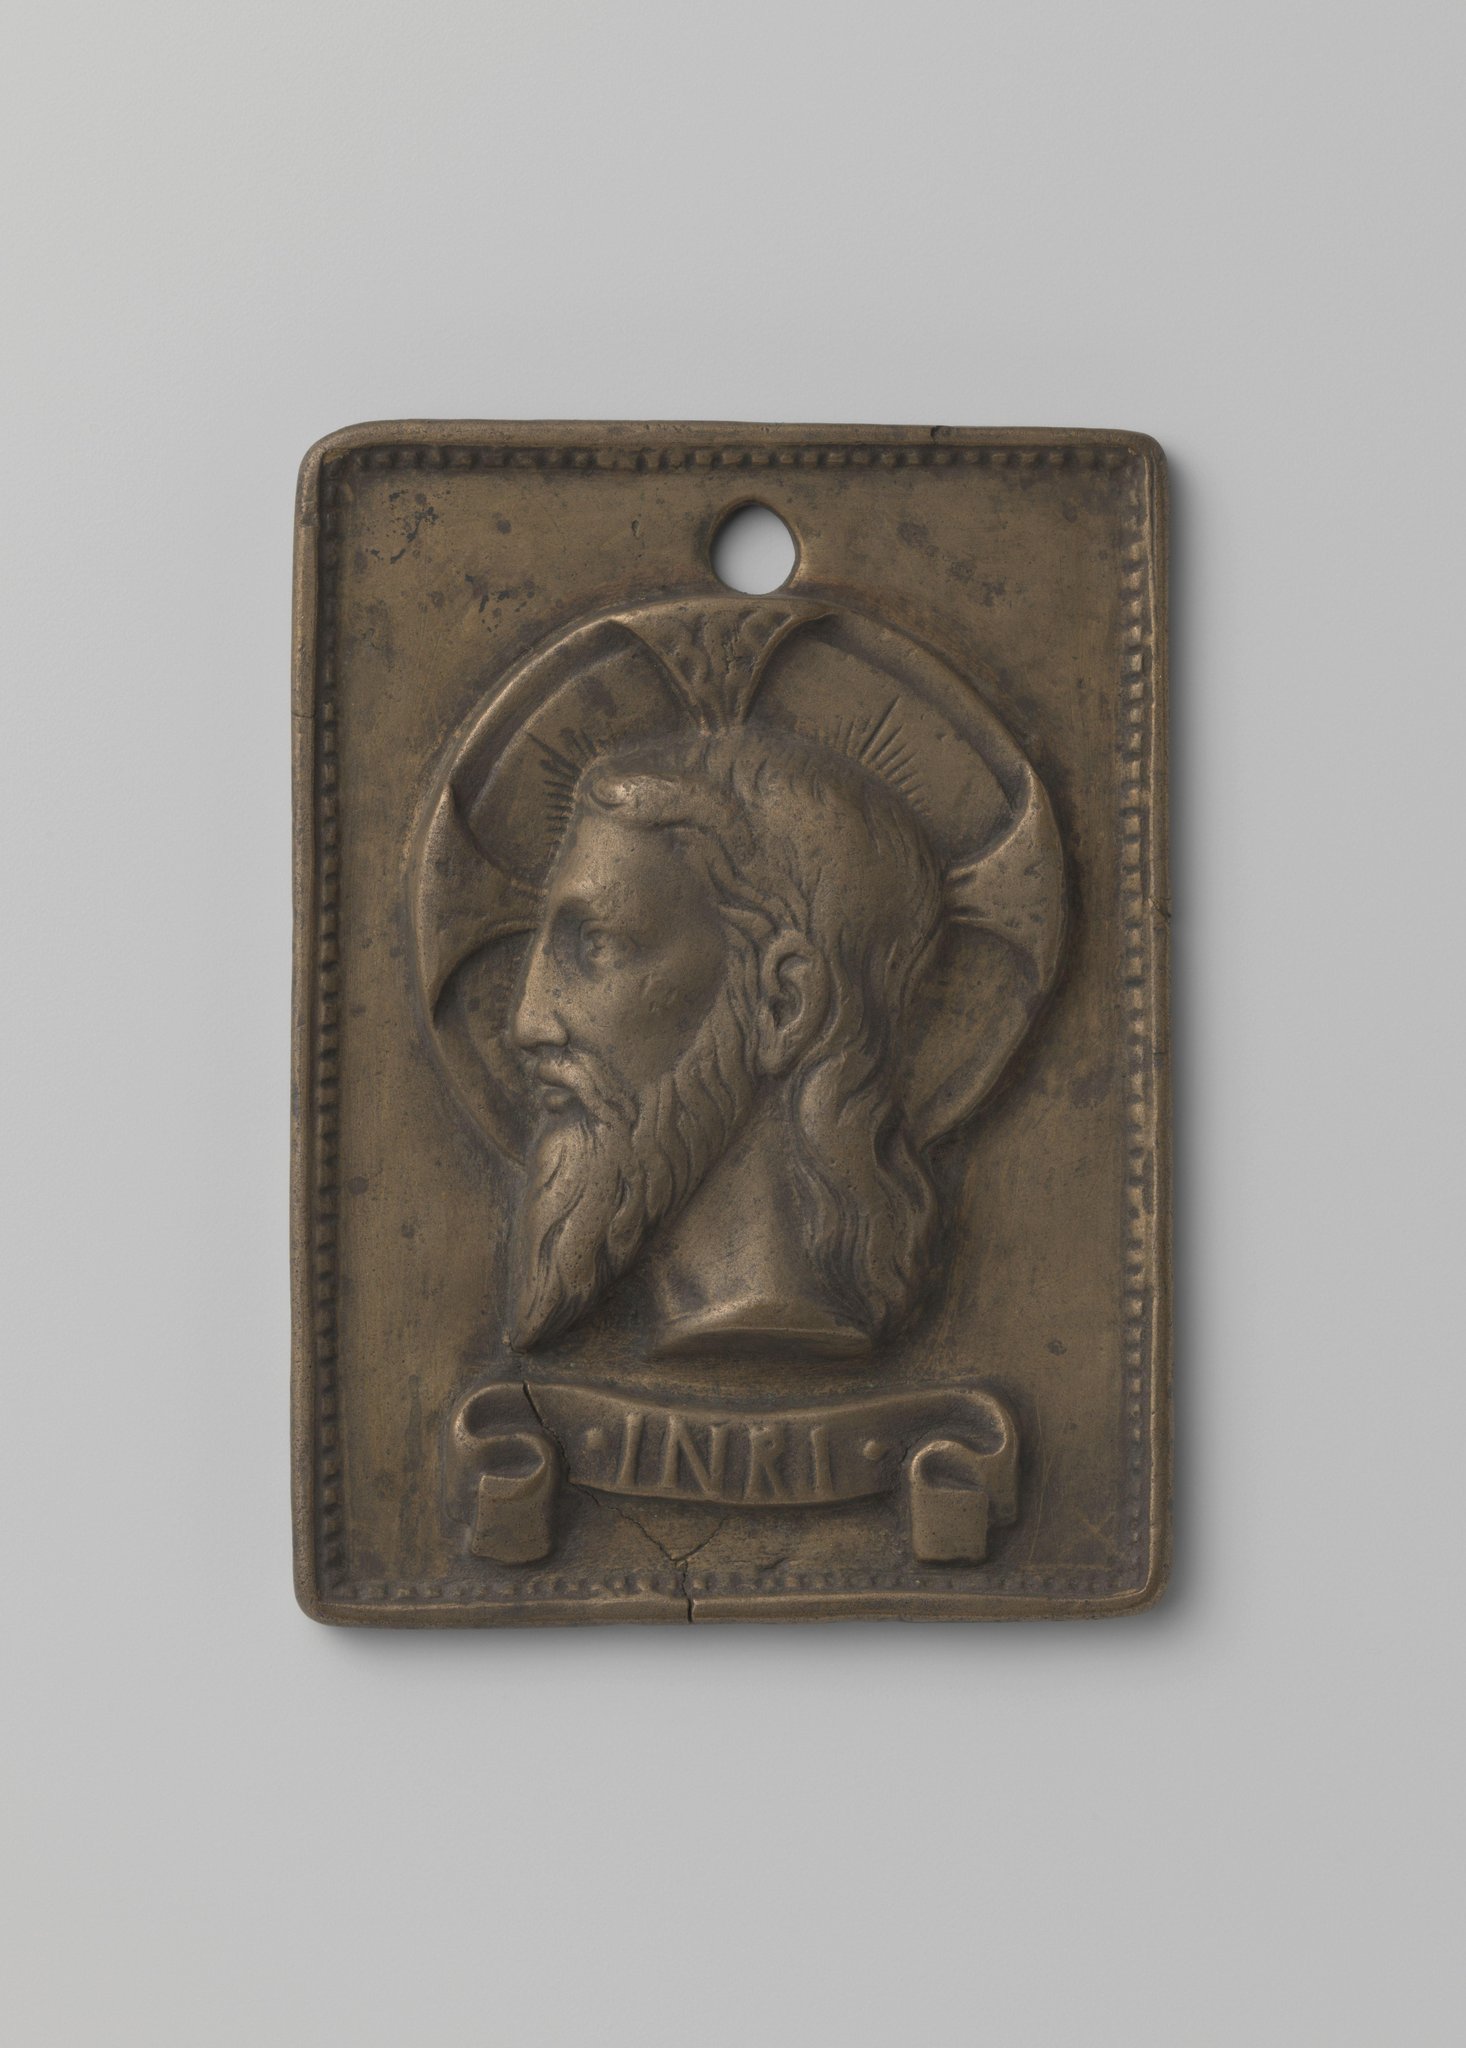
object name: plaque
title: Plaquette met het hoofd van Christus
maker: Anonymous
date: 1800-1900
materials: copper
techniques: casting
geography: western europe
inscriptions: inscription: ‘INRI’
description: Op de als één geheel gegoten plaquette is het hoofd van Christus in reliëf uitgebeeld, omgeven door een nimbus, waarin een kruis is aangbracht. Daaronder de banderol met het opschrift INRI.